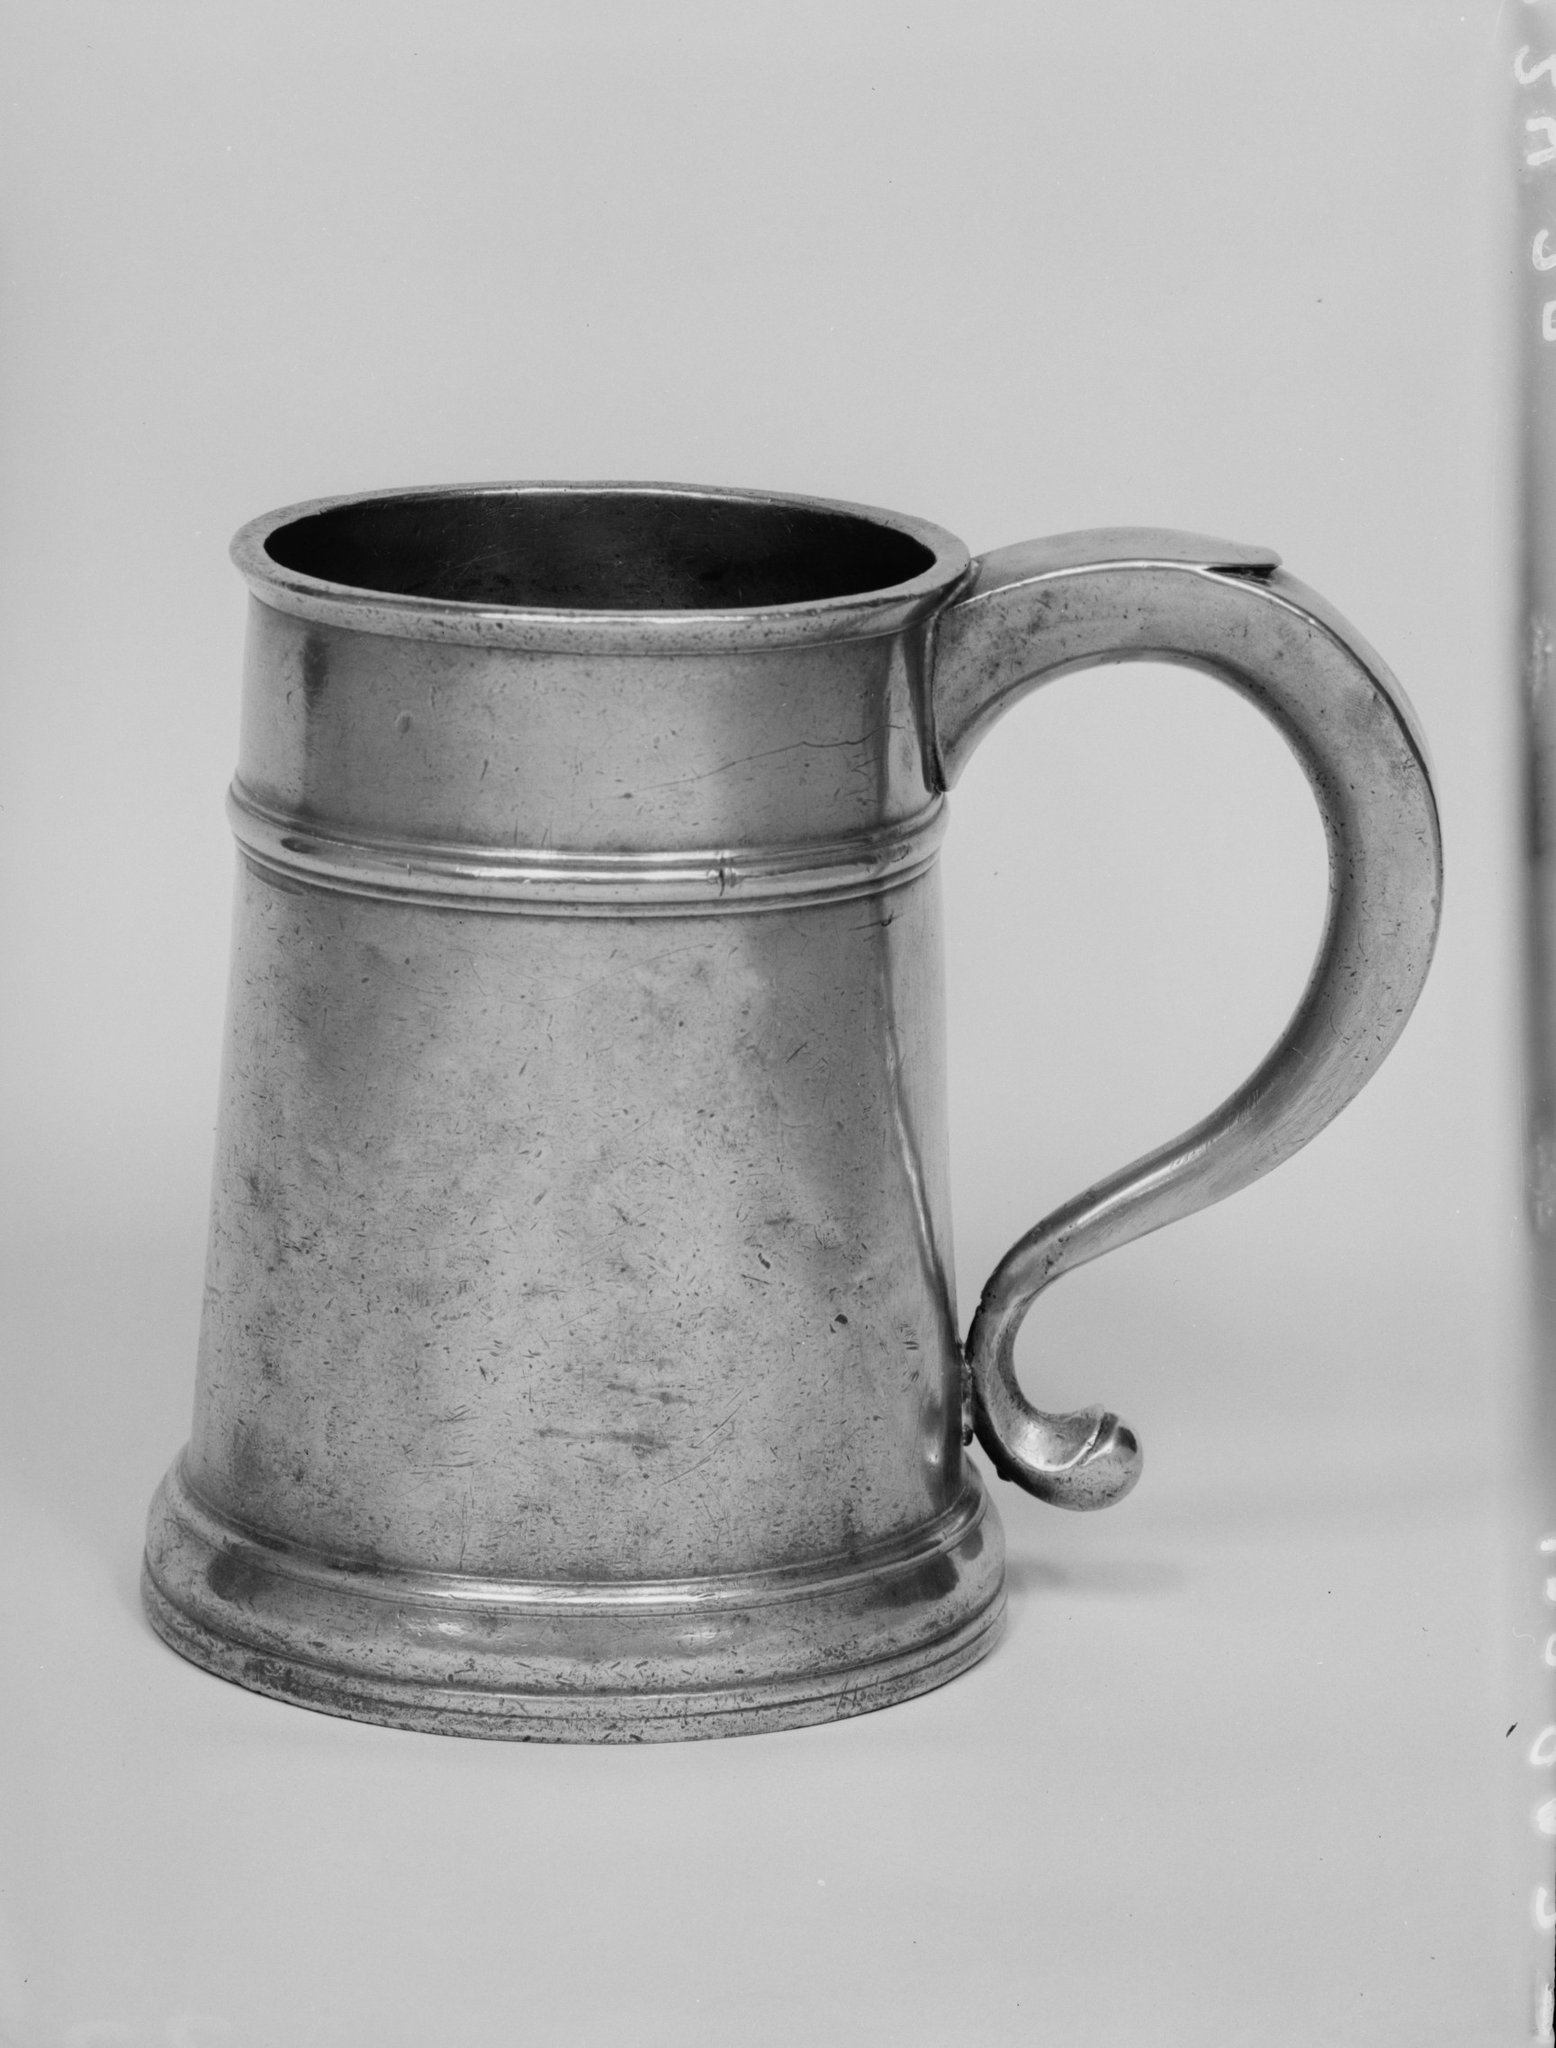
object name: mug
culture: american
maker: frederick bassett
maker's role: maker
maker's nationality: american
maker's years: 1740-1800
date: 1761-1799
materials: pewter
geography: united states